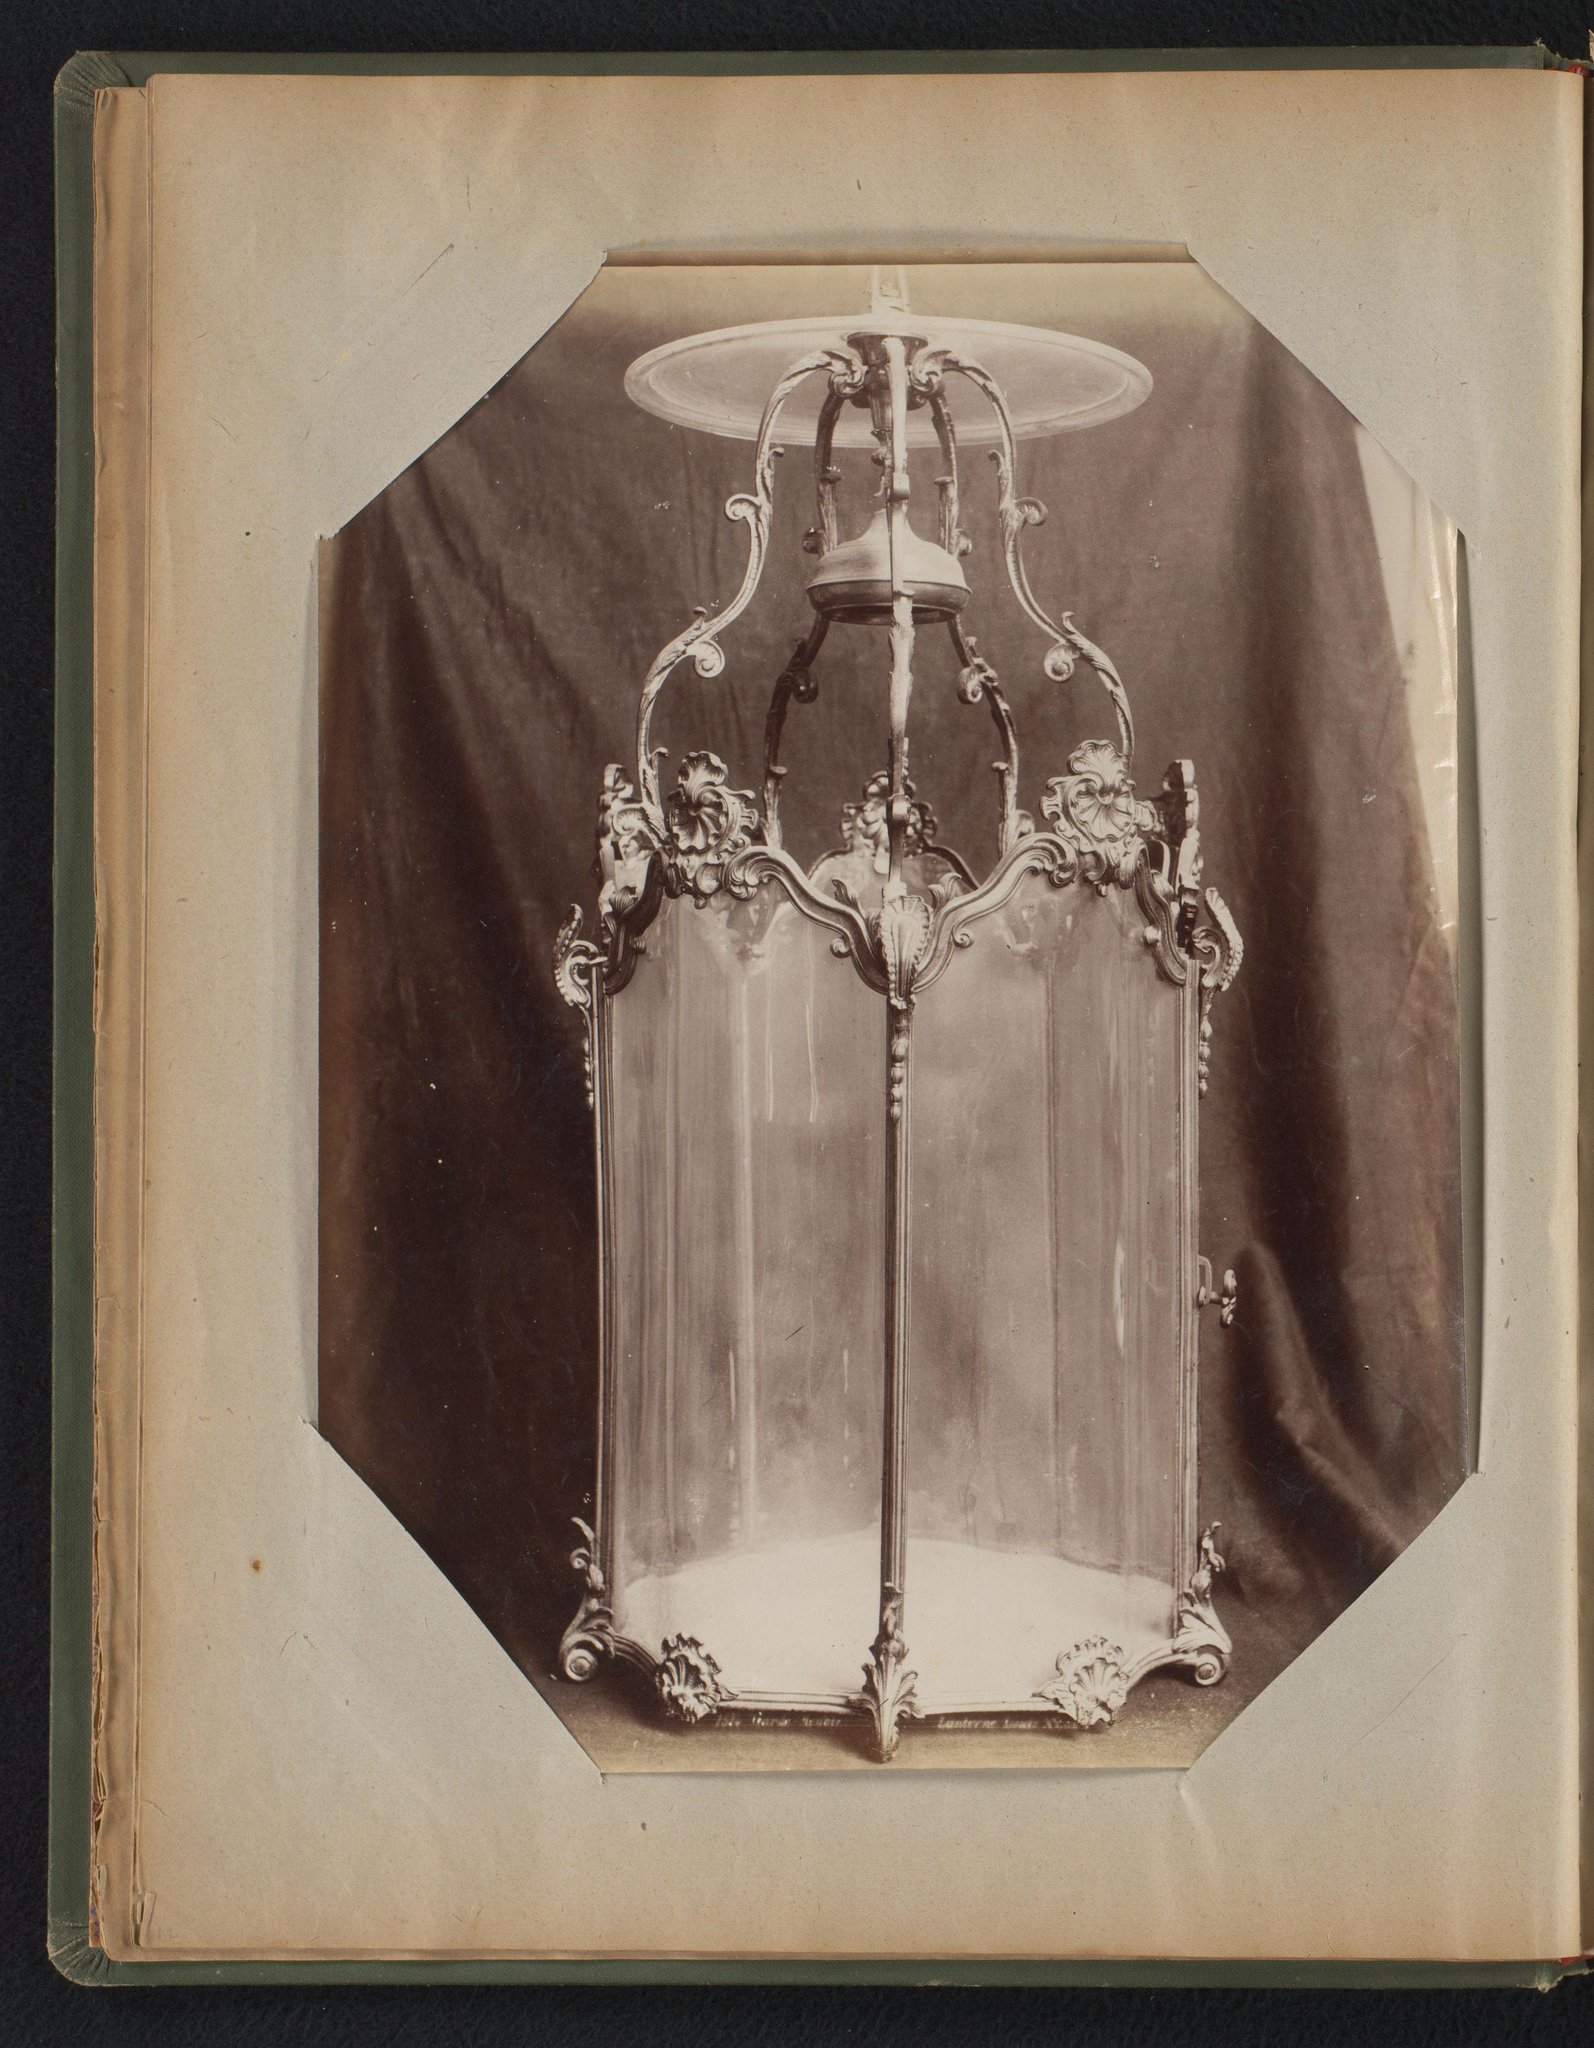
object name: photograph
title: Lantaarn bestaande uit brons en glas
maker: Anonymous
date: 1860-1900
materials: canvas, cardboard, paper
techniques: matte daylight collodion silver print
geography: netherlands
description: De glazen van de tafellantaarn zijn van elkaar gescheiden door smalle van ornamenten voorziene bronzen pootjes.